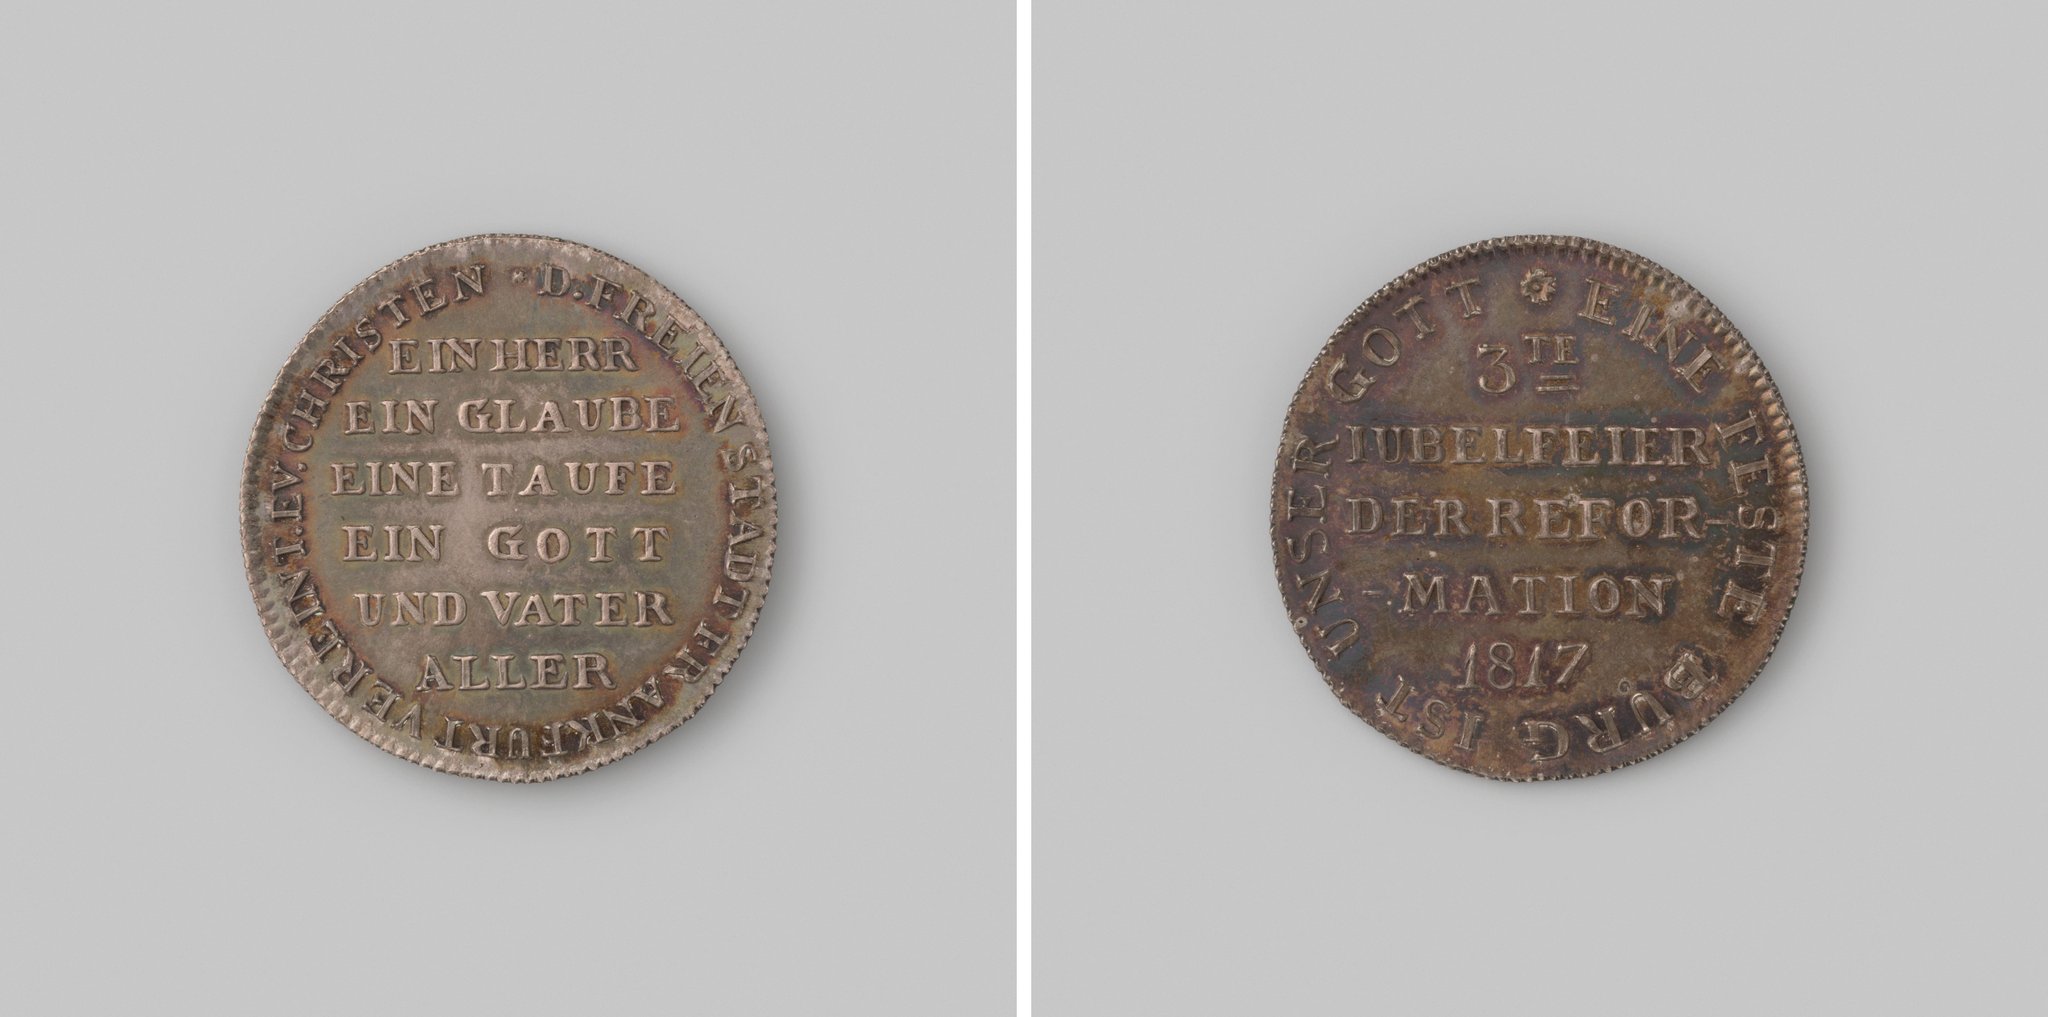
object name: history medal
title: Driehonderdjarige herdenking van de Reformatie te Frankfurt 1817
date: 1817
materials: silver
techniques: striking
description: Zilveren penning, op de voorzijde zes regels tekst met omschrift, op de keerzijde vijf regels tekst met omschrift, met kartelrand.